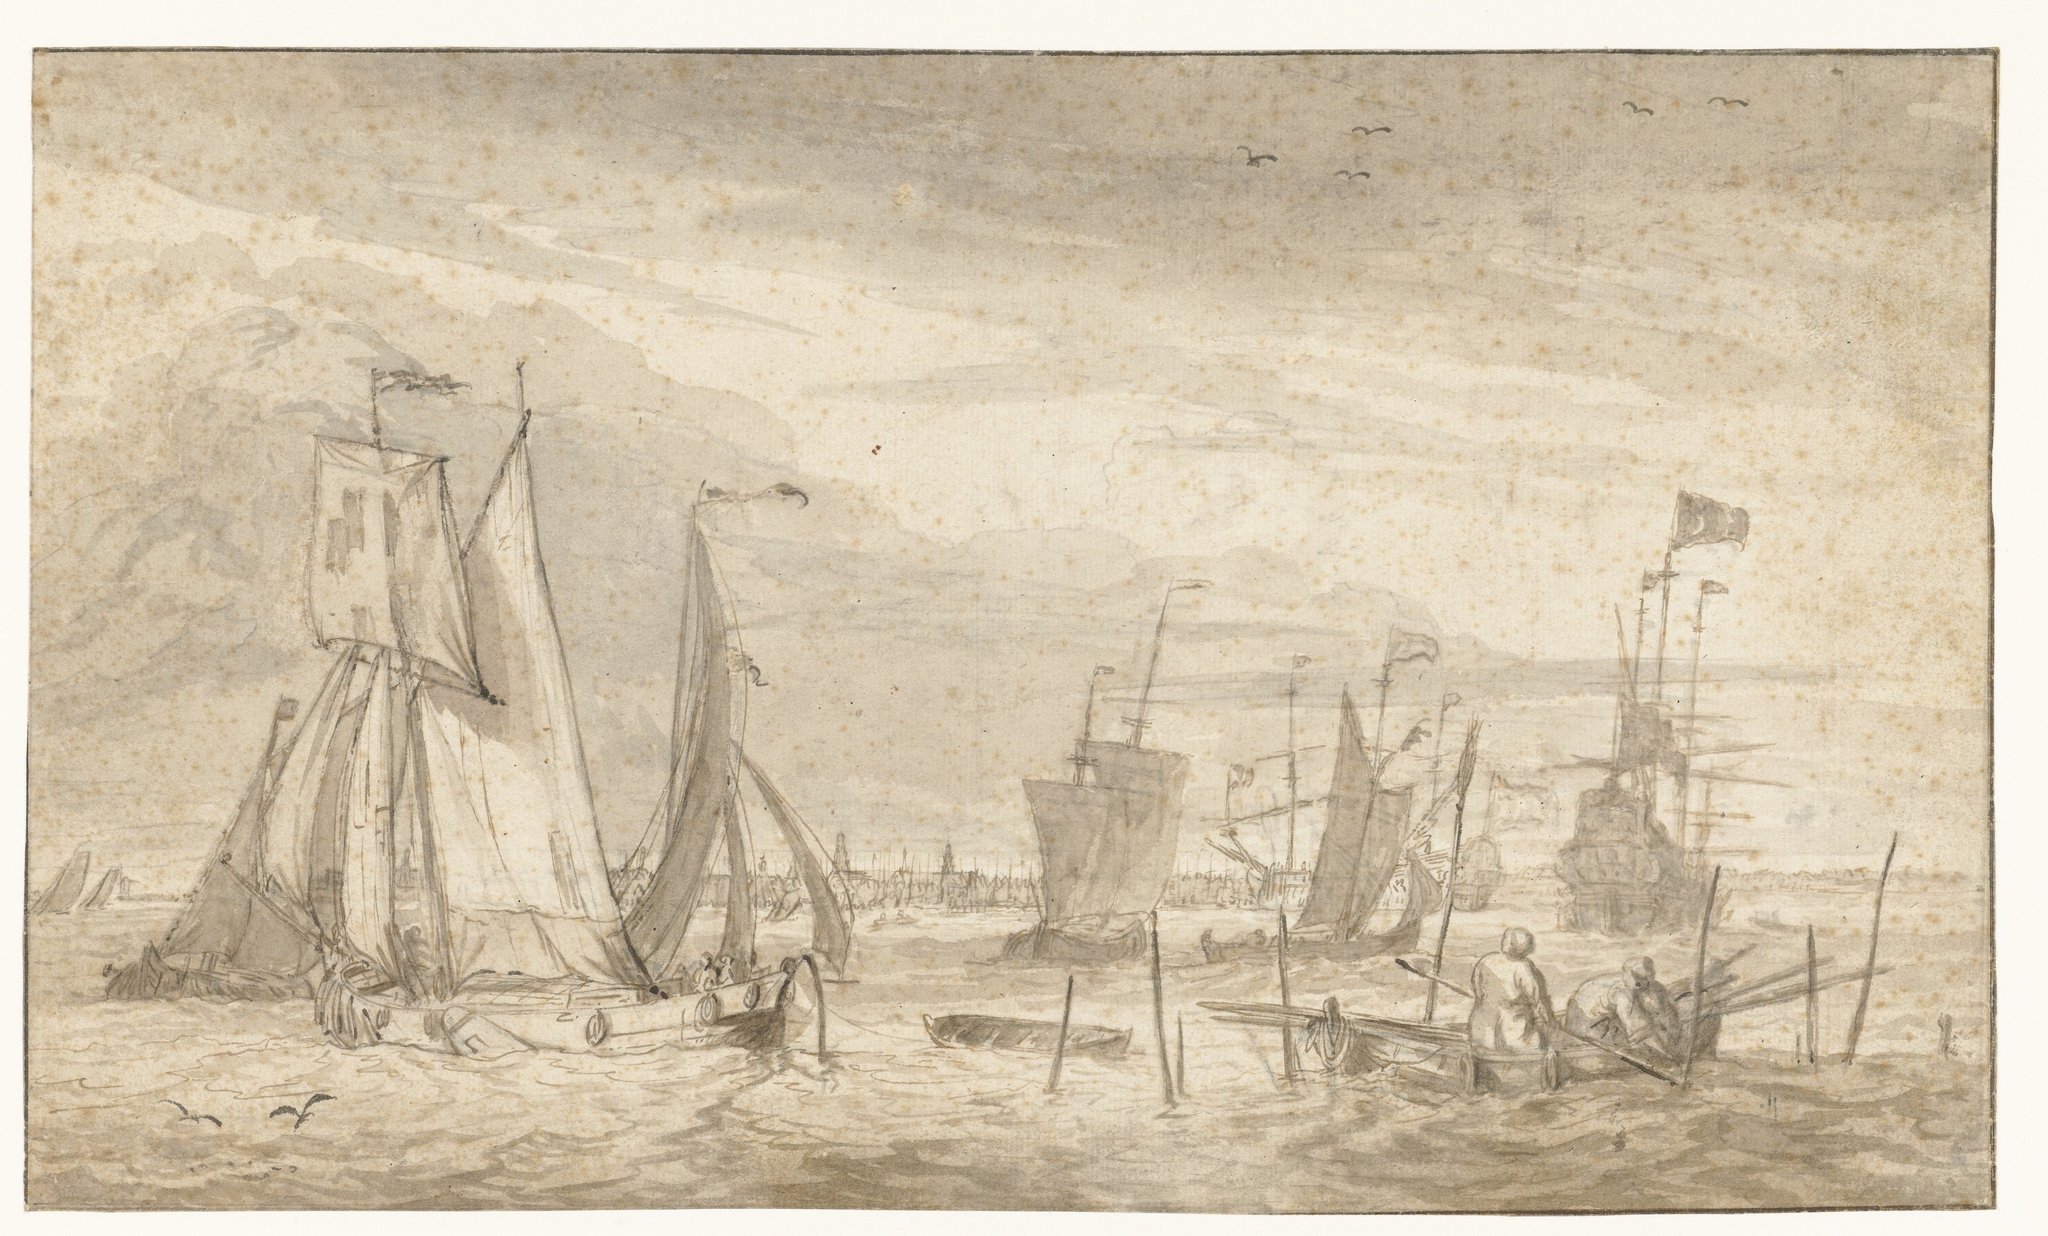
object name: drawing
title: Druk bevaren rivier voor een stadsprofiel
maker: pieter coopse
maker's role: draughtsman, print maker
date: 1668-1677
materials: ink, paper, pencil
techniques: brush, pen